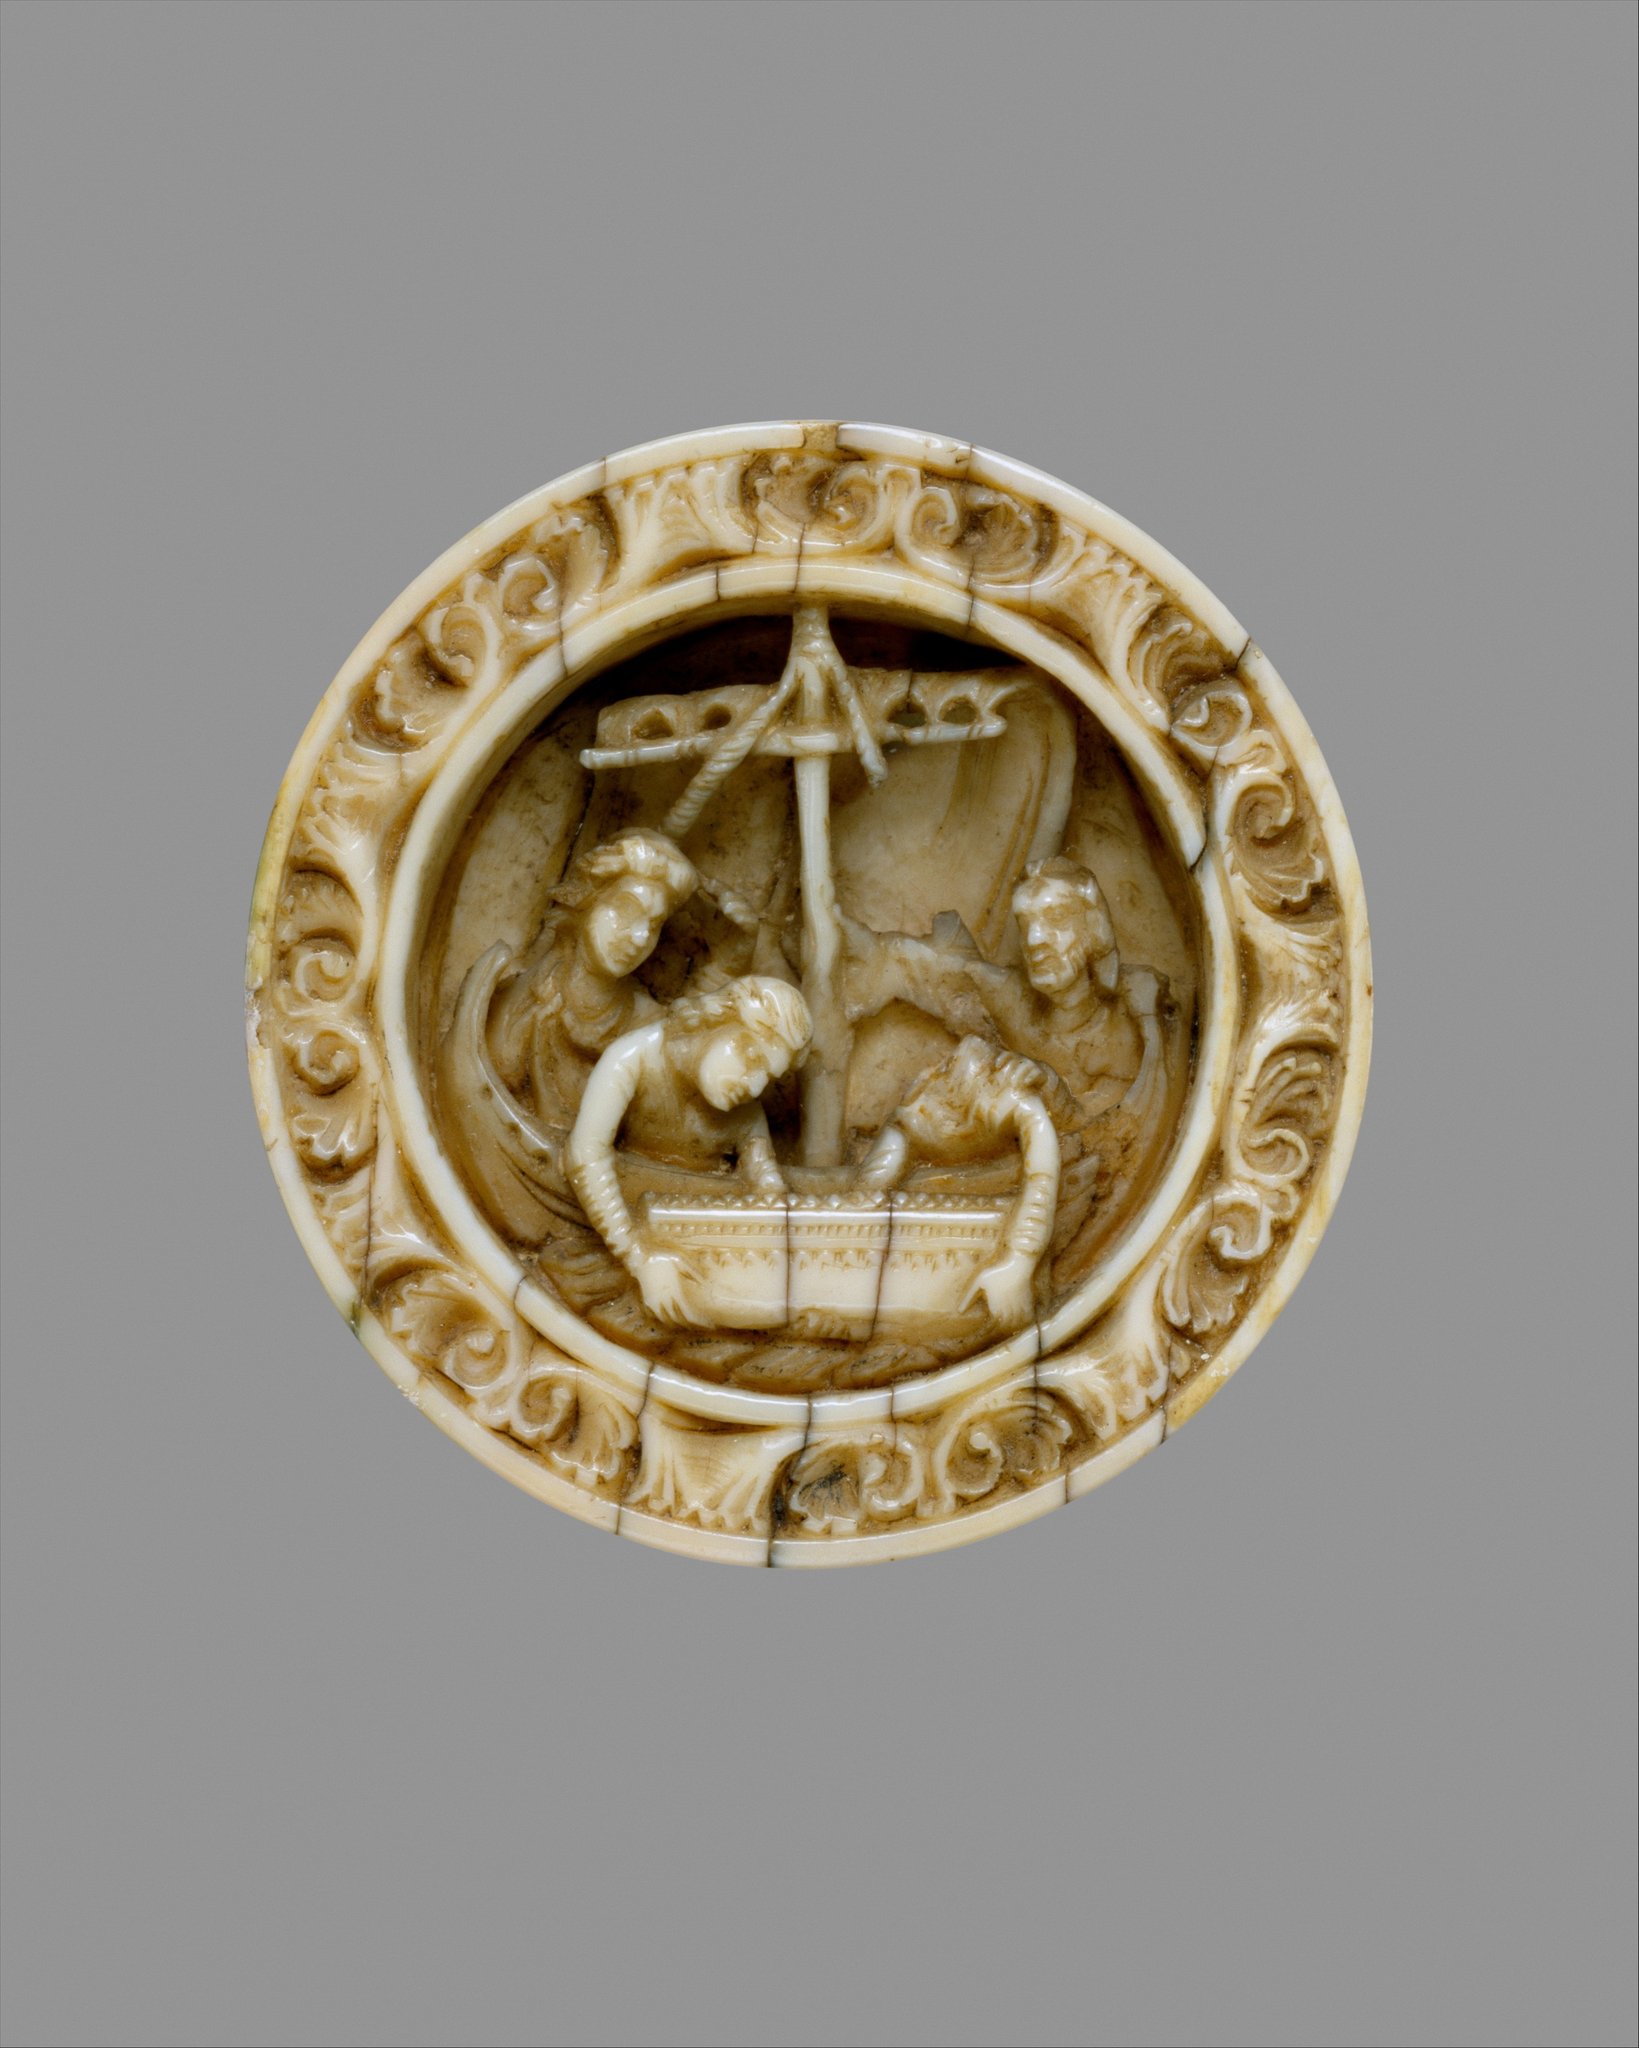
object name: game piece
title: Game Piece with a Scene from the Life of Apollonius of Tyre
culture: german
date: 1170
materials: ivory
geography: germany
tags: men,boats,games